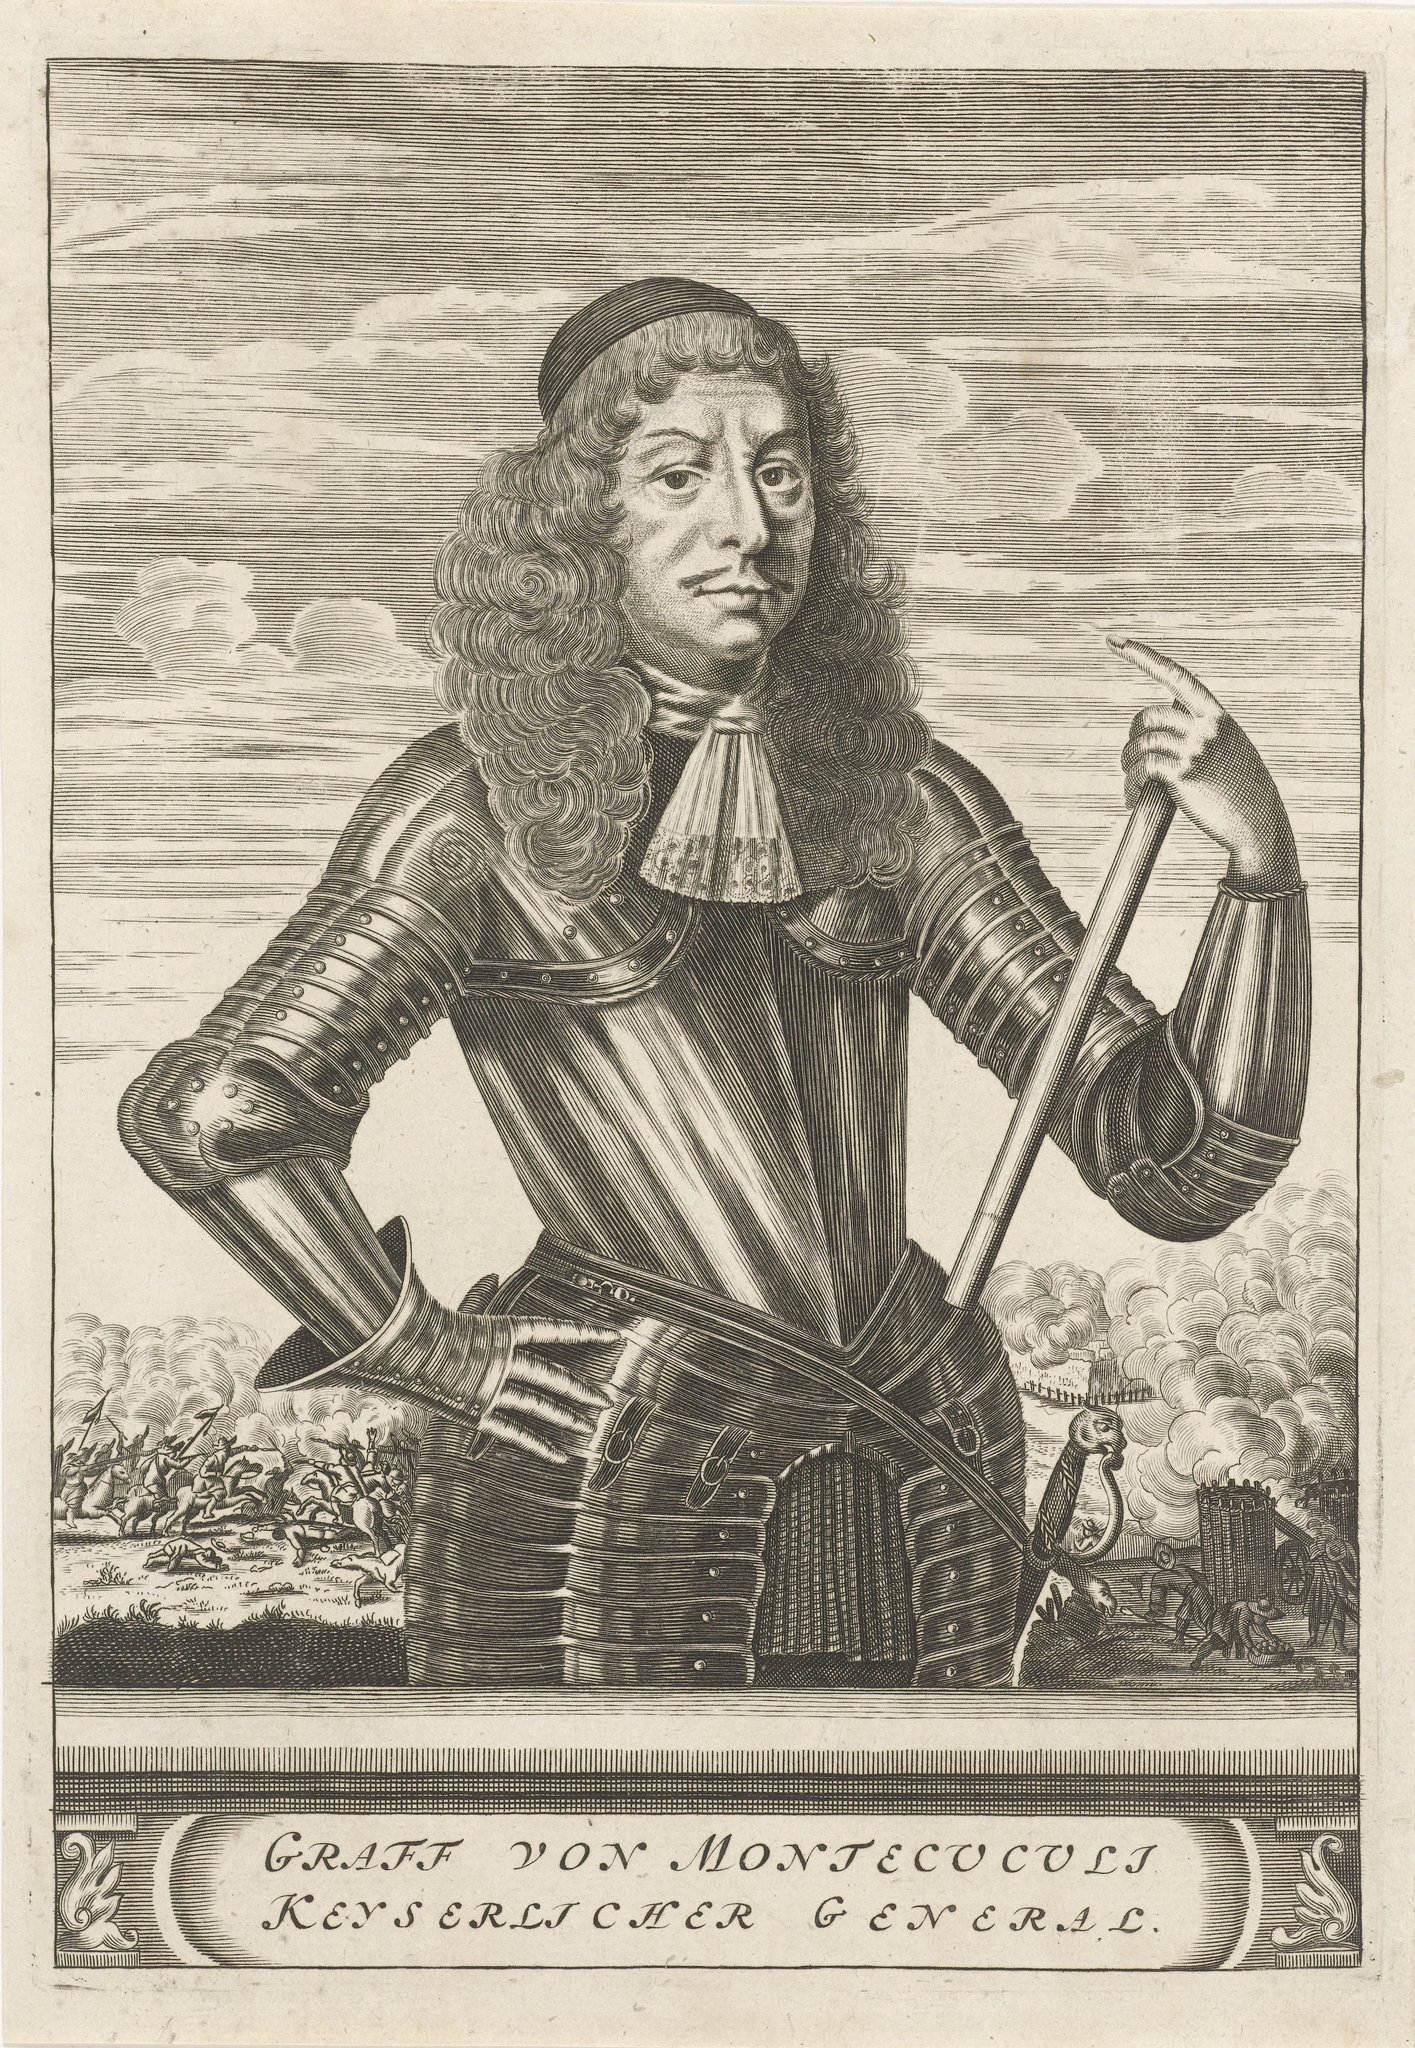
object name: print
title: Portret van Raimondo graaf van Montecuccoli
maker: christiaan hagen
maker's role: draughtsman, print maker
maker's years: 1635-1707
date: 1663-1695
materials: paper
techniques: engraving, etching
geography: amsterdam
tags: armour, battle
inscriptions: collector's mark: Lugt 2228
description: Portret naar rechts van Raimondo graaf van Montecuccoli. Hij draagt een harnas, in zijn linkerhand houdt hij een commandostaf. Op de achtergrond is een veldslag afgebeeld. Onder zijn portret een plint, waarop zijn naam en titel in twee regels in een cartouche.